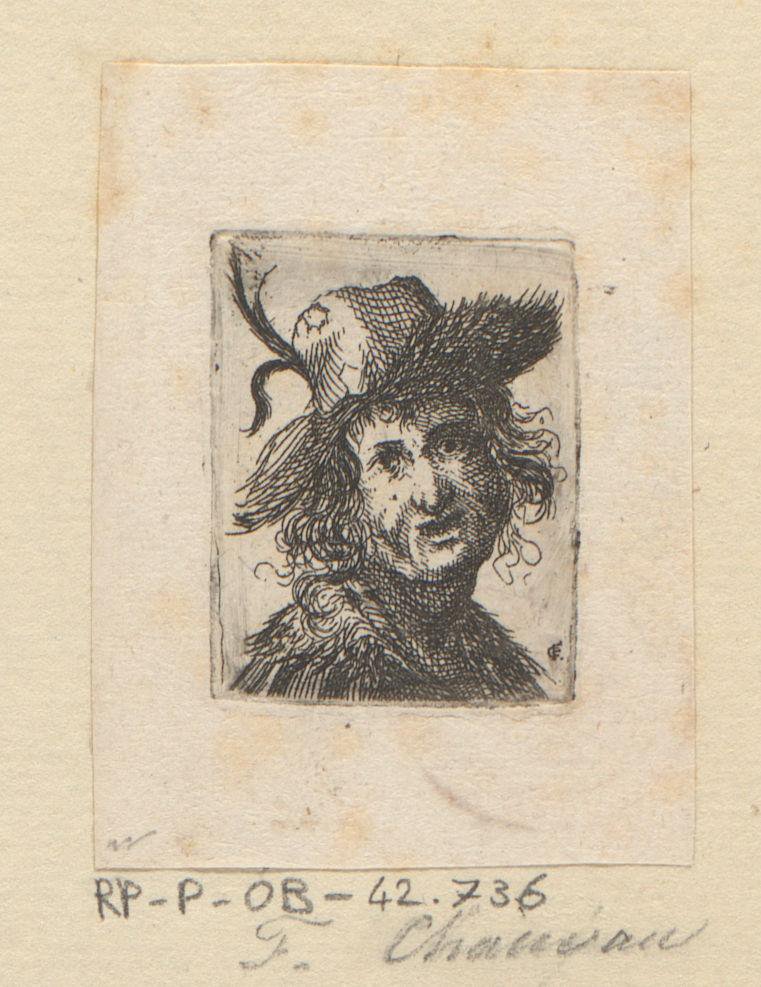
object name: print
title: Man met een hoed met veer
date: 1623-1676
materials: paper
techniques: etching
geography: france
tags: adult man, head-gear: hat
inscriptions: collector's mark: Lugt 240